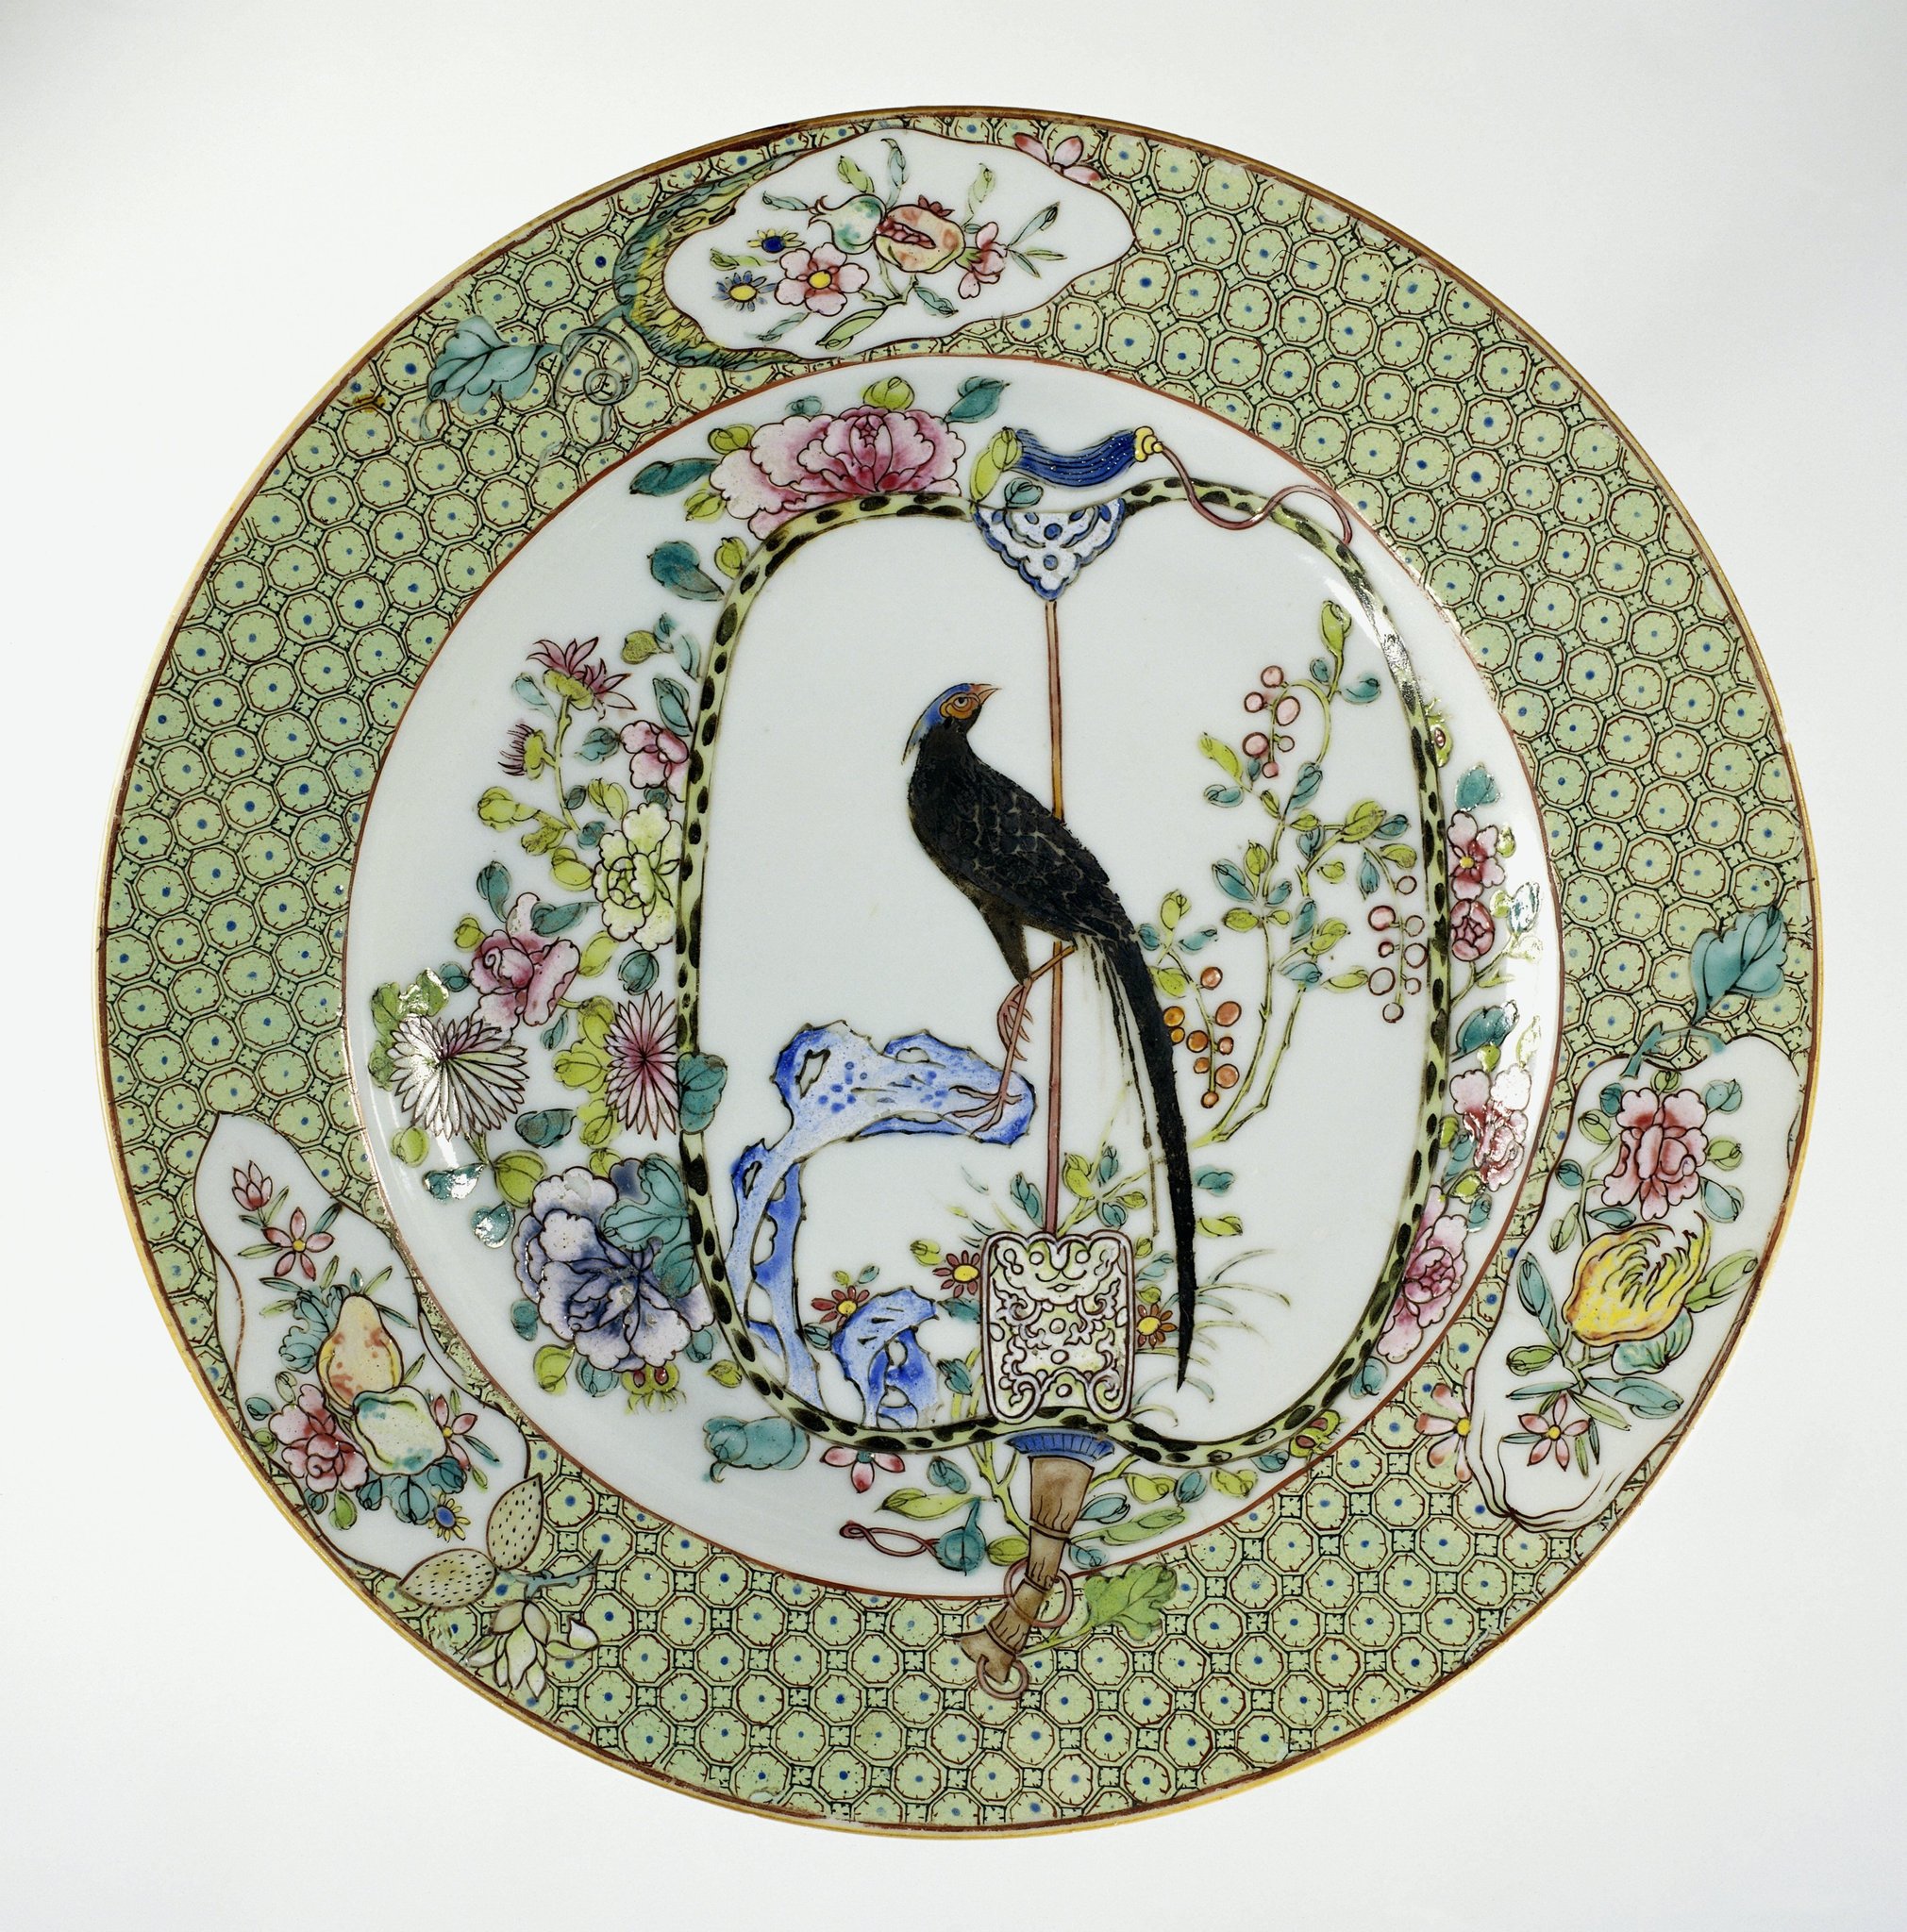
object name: plate dish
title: Plate with a fan decorated with a pheasant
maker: Anonymous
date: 1730-1745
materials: glaze, gold, paint, porcelain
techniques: firing, gilding, turning, vitrification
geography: china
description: Bord van porselein, in 'famille-rose'. In het plat een waaier met steel waarin een fazant op een rotspunt zit omringd met struiken. Met gedecoreerde platte rand.